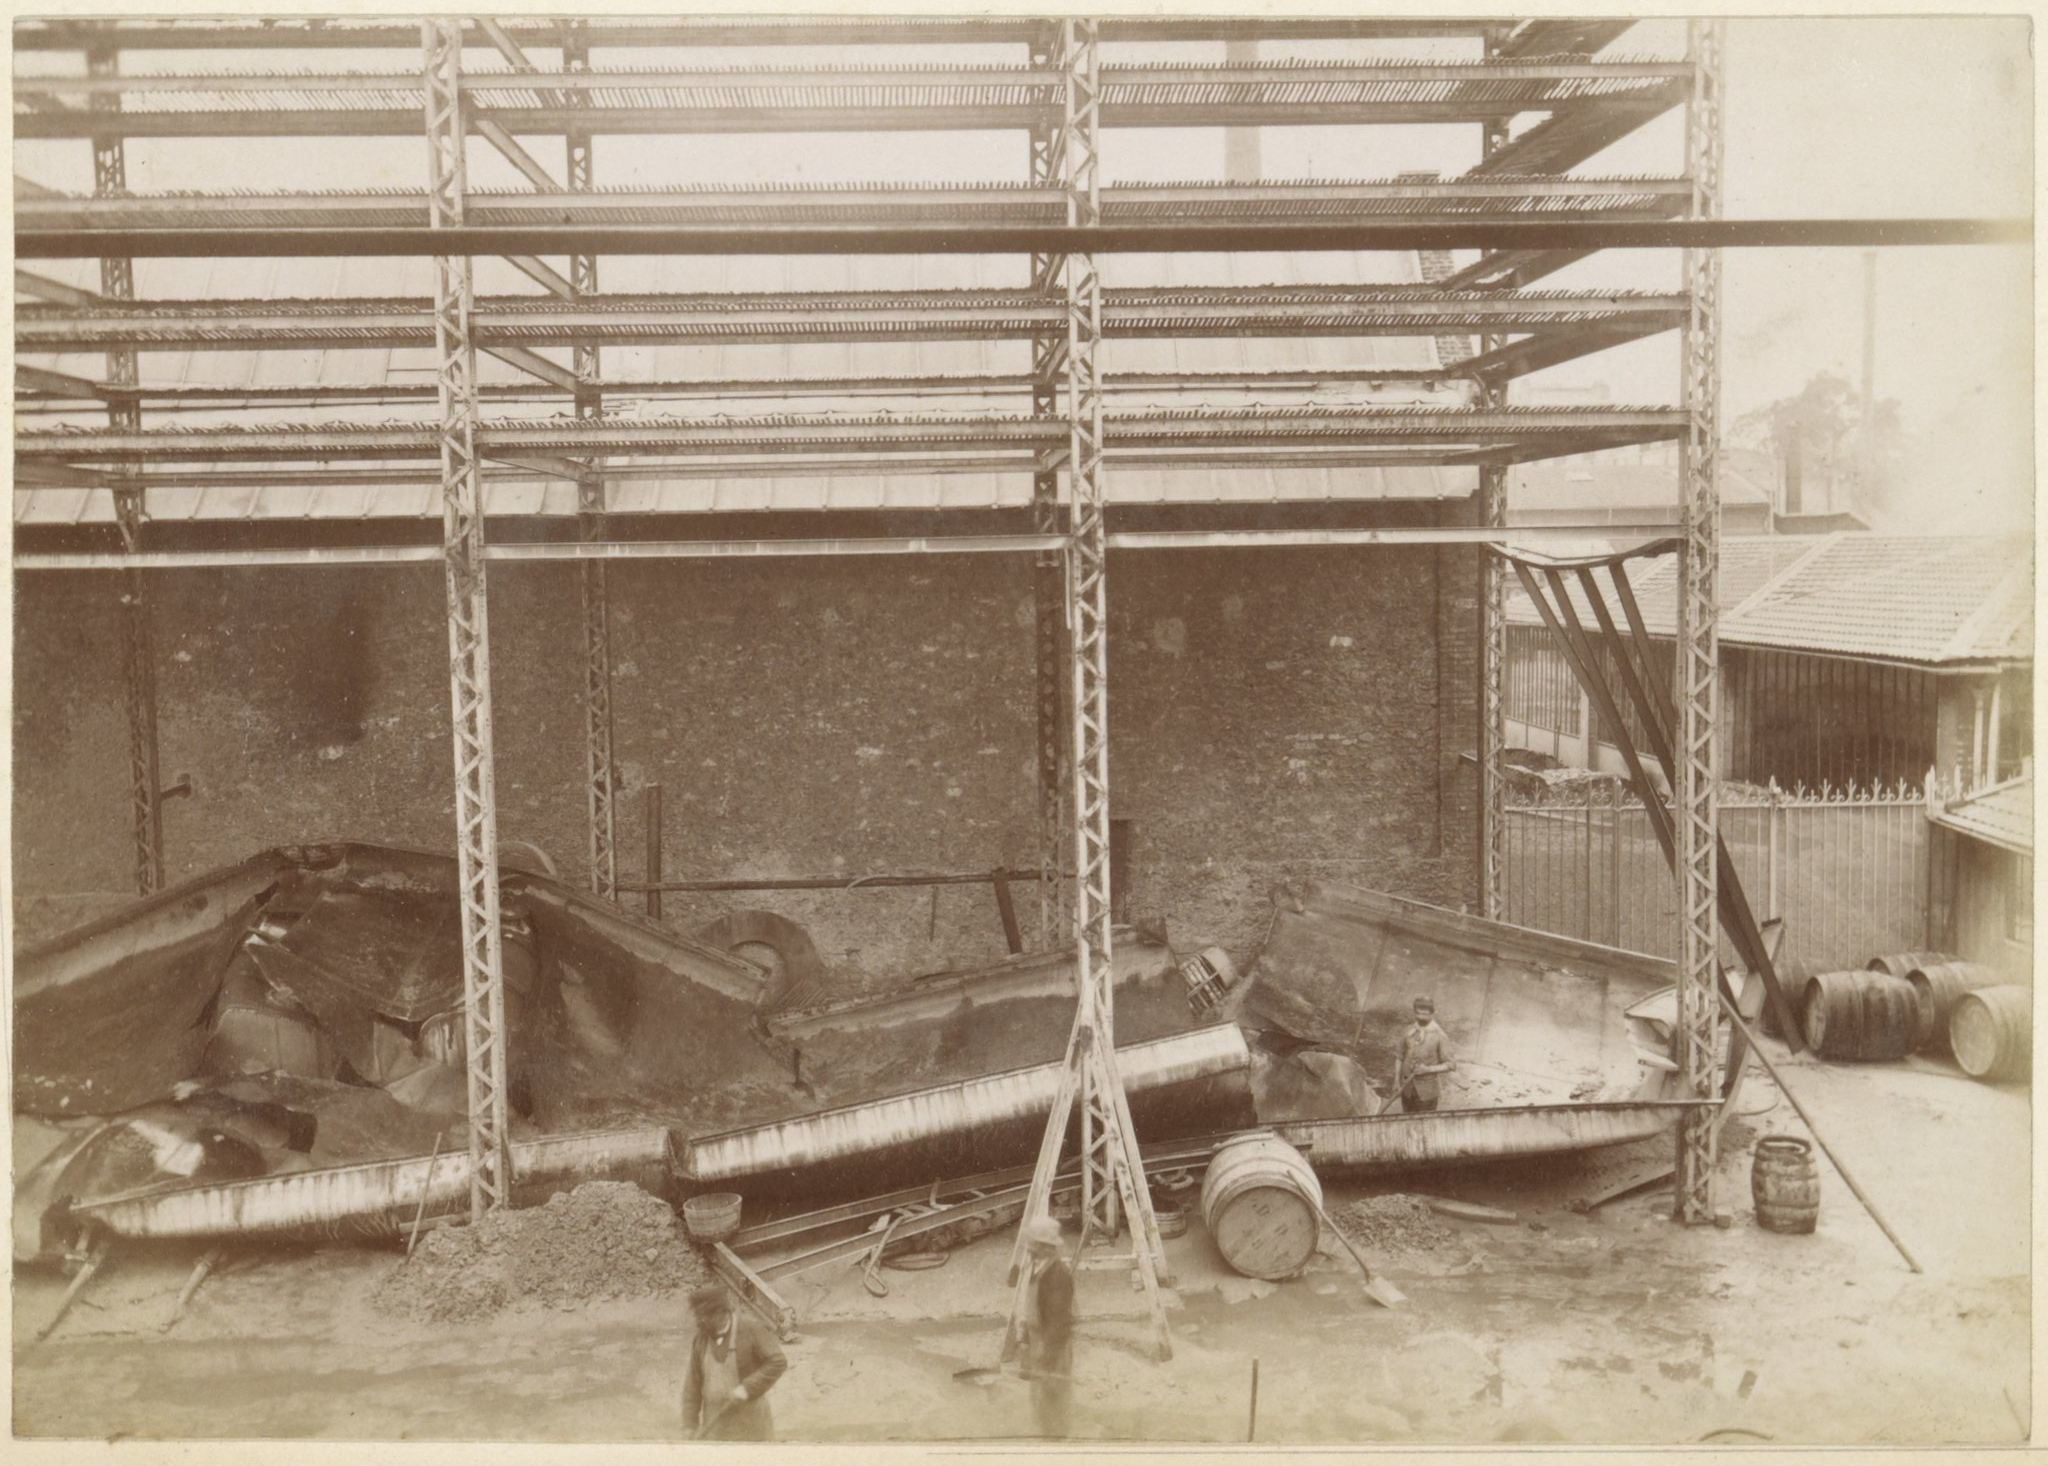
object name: photograph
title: Rek met schroot eronder, vermoedelijk op het terrein van distilleerderij Delizy & Doistau Fils in Pantin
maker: Anonymous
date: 1900-1910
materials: paper, photographic support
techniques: albumen print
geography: pantin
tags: shelves, rack, sideboard, litter, rubbish, garbage ~ street sweeping, bottling of wine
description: Onderdeel van Fotoalbum van een Franse amateurfotograaf met opnames van een familie, distilleerderij Delizy & Doistau Fils, het leger en bezienswaardigheden in Frankrijk.